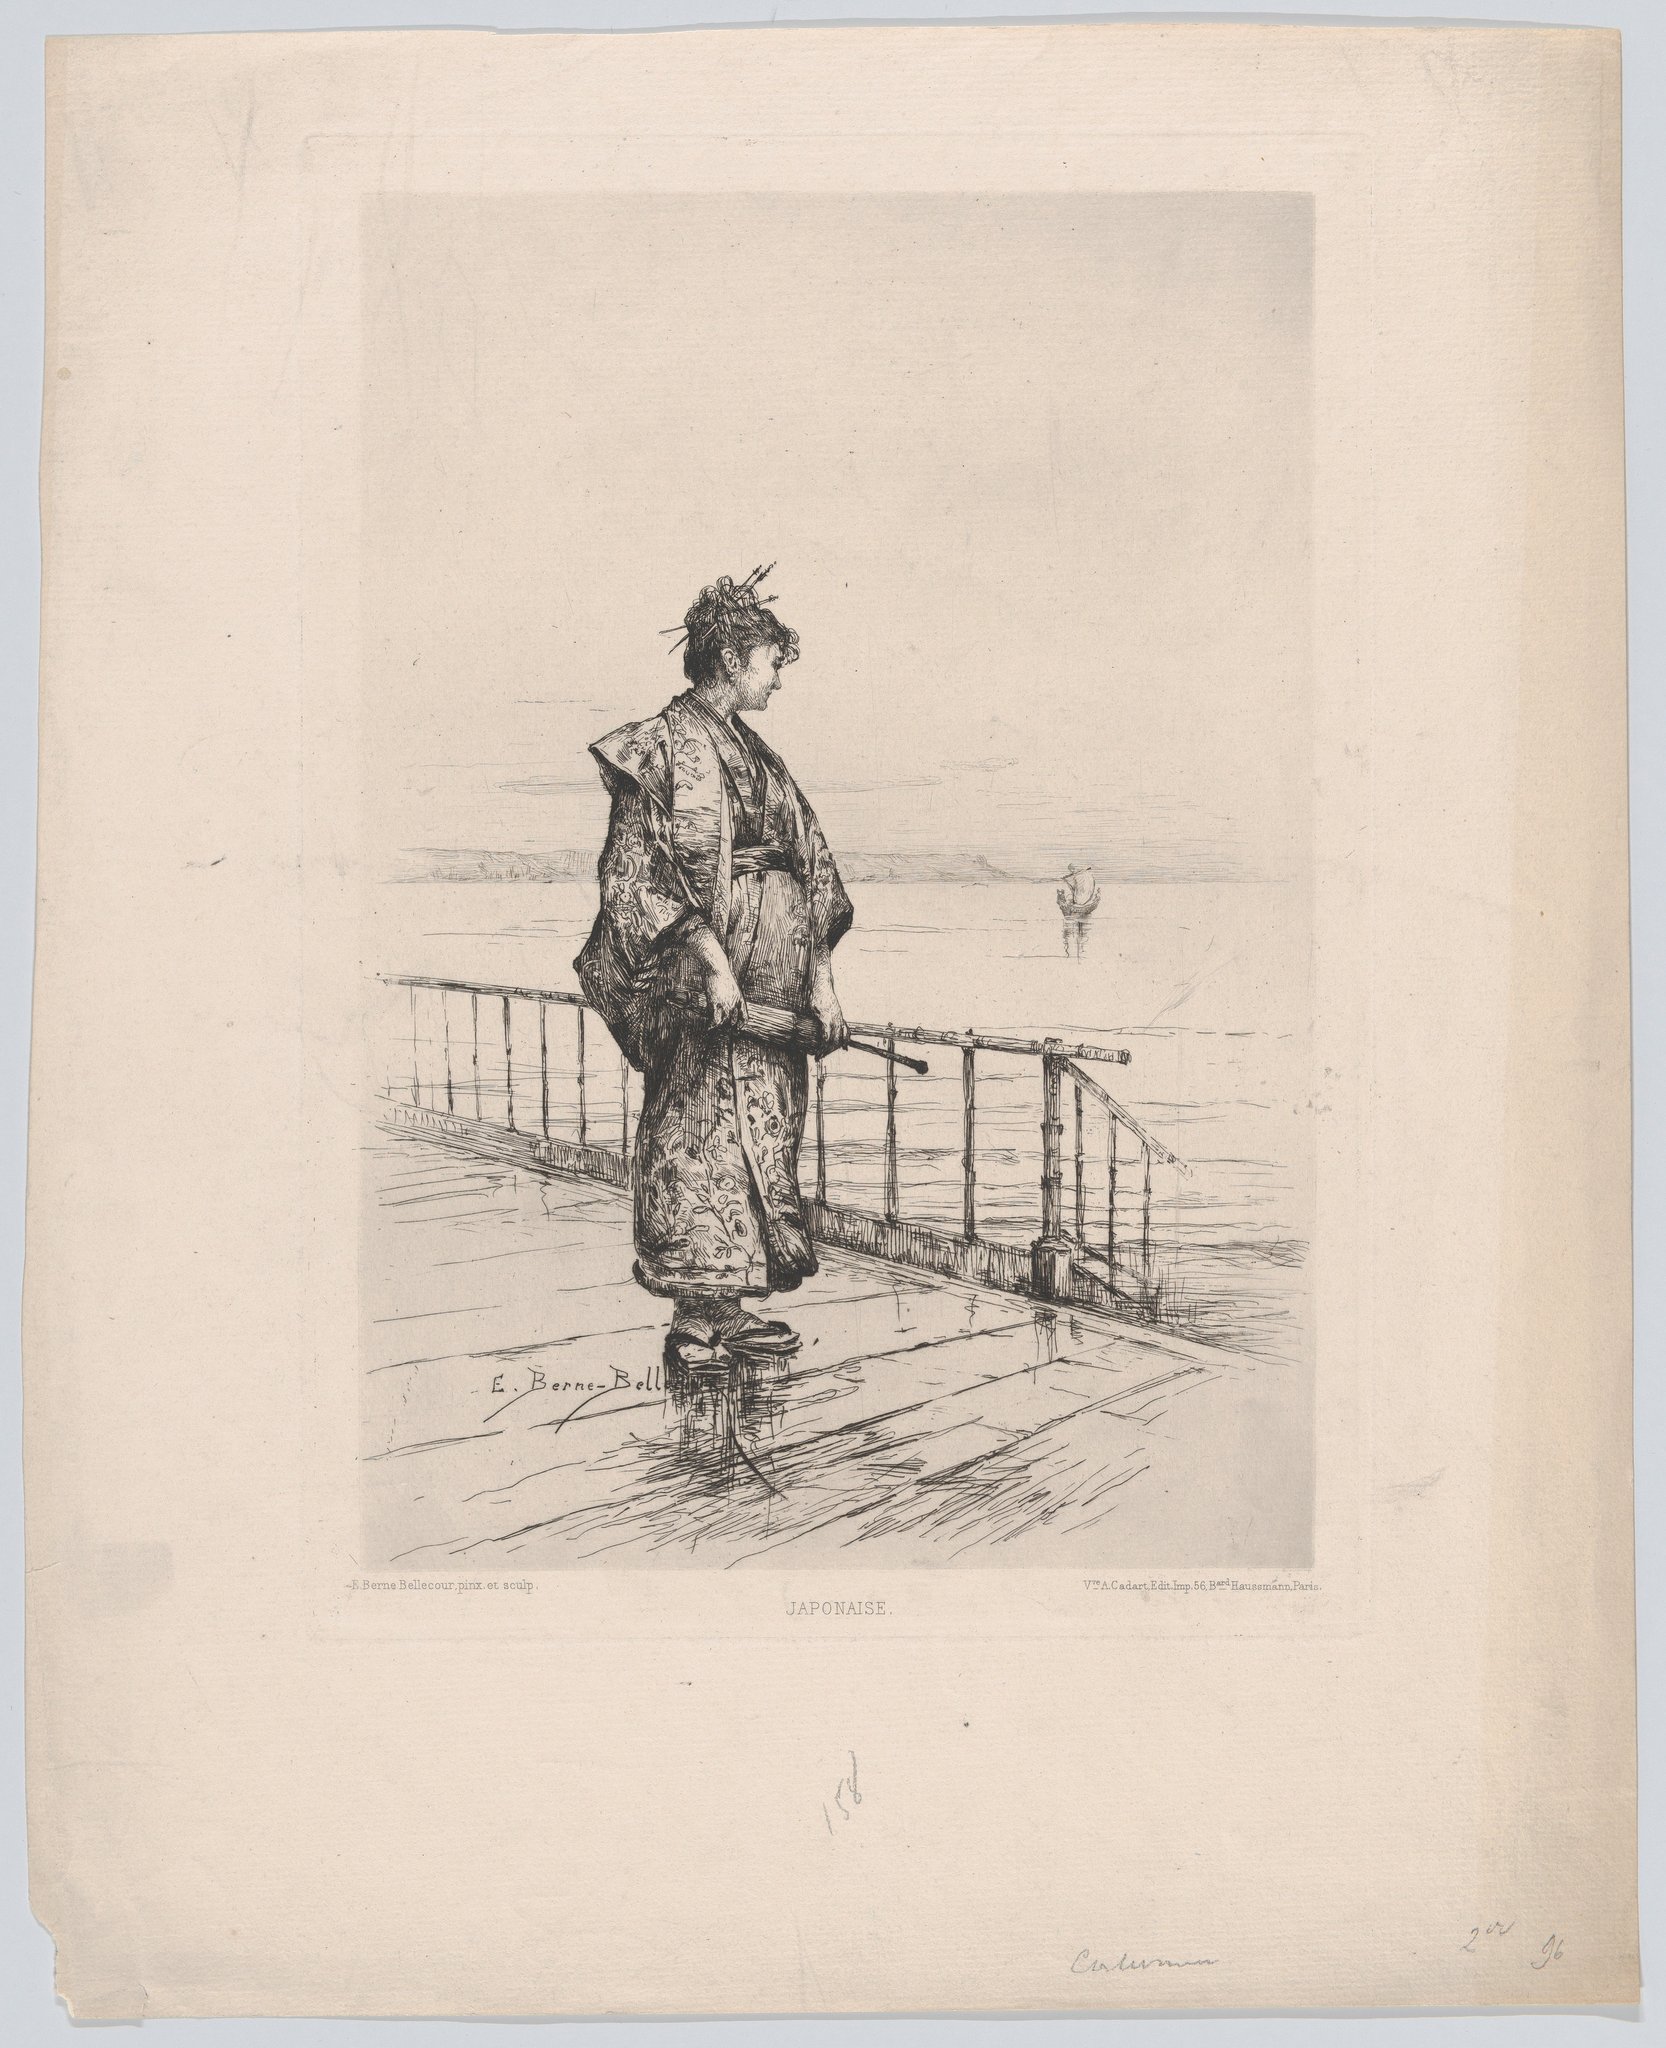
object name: print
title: The Japonese Woman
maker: etienne-prosper berne-bellecour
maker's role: artist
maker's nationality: french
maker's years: 1838-1910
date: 1877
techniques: drypoint, etching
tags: profiles,women